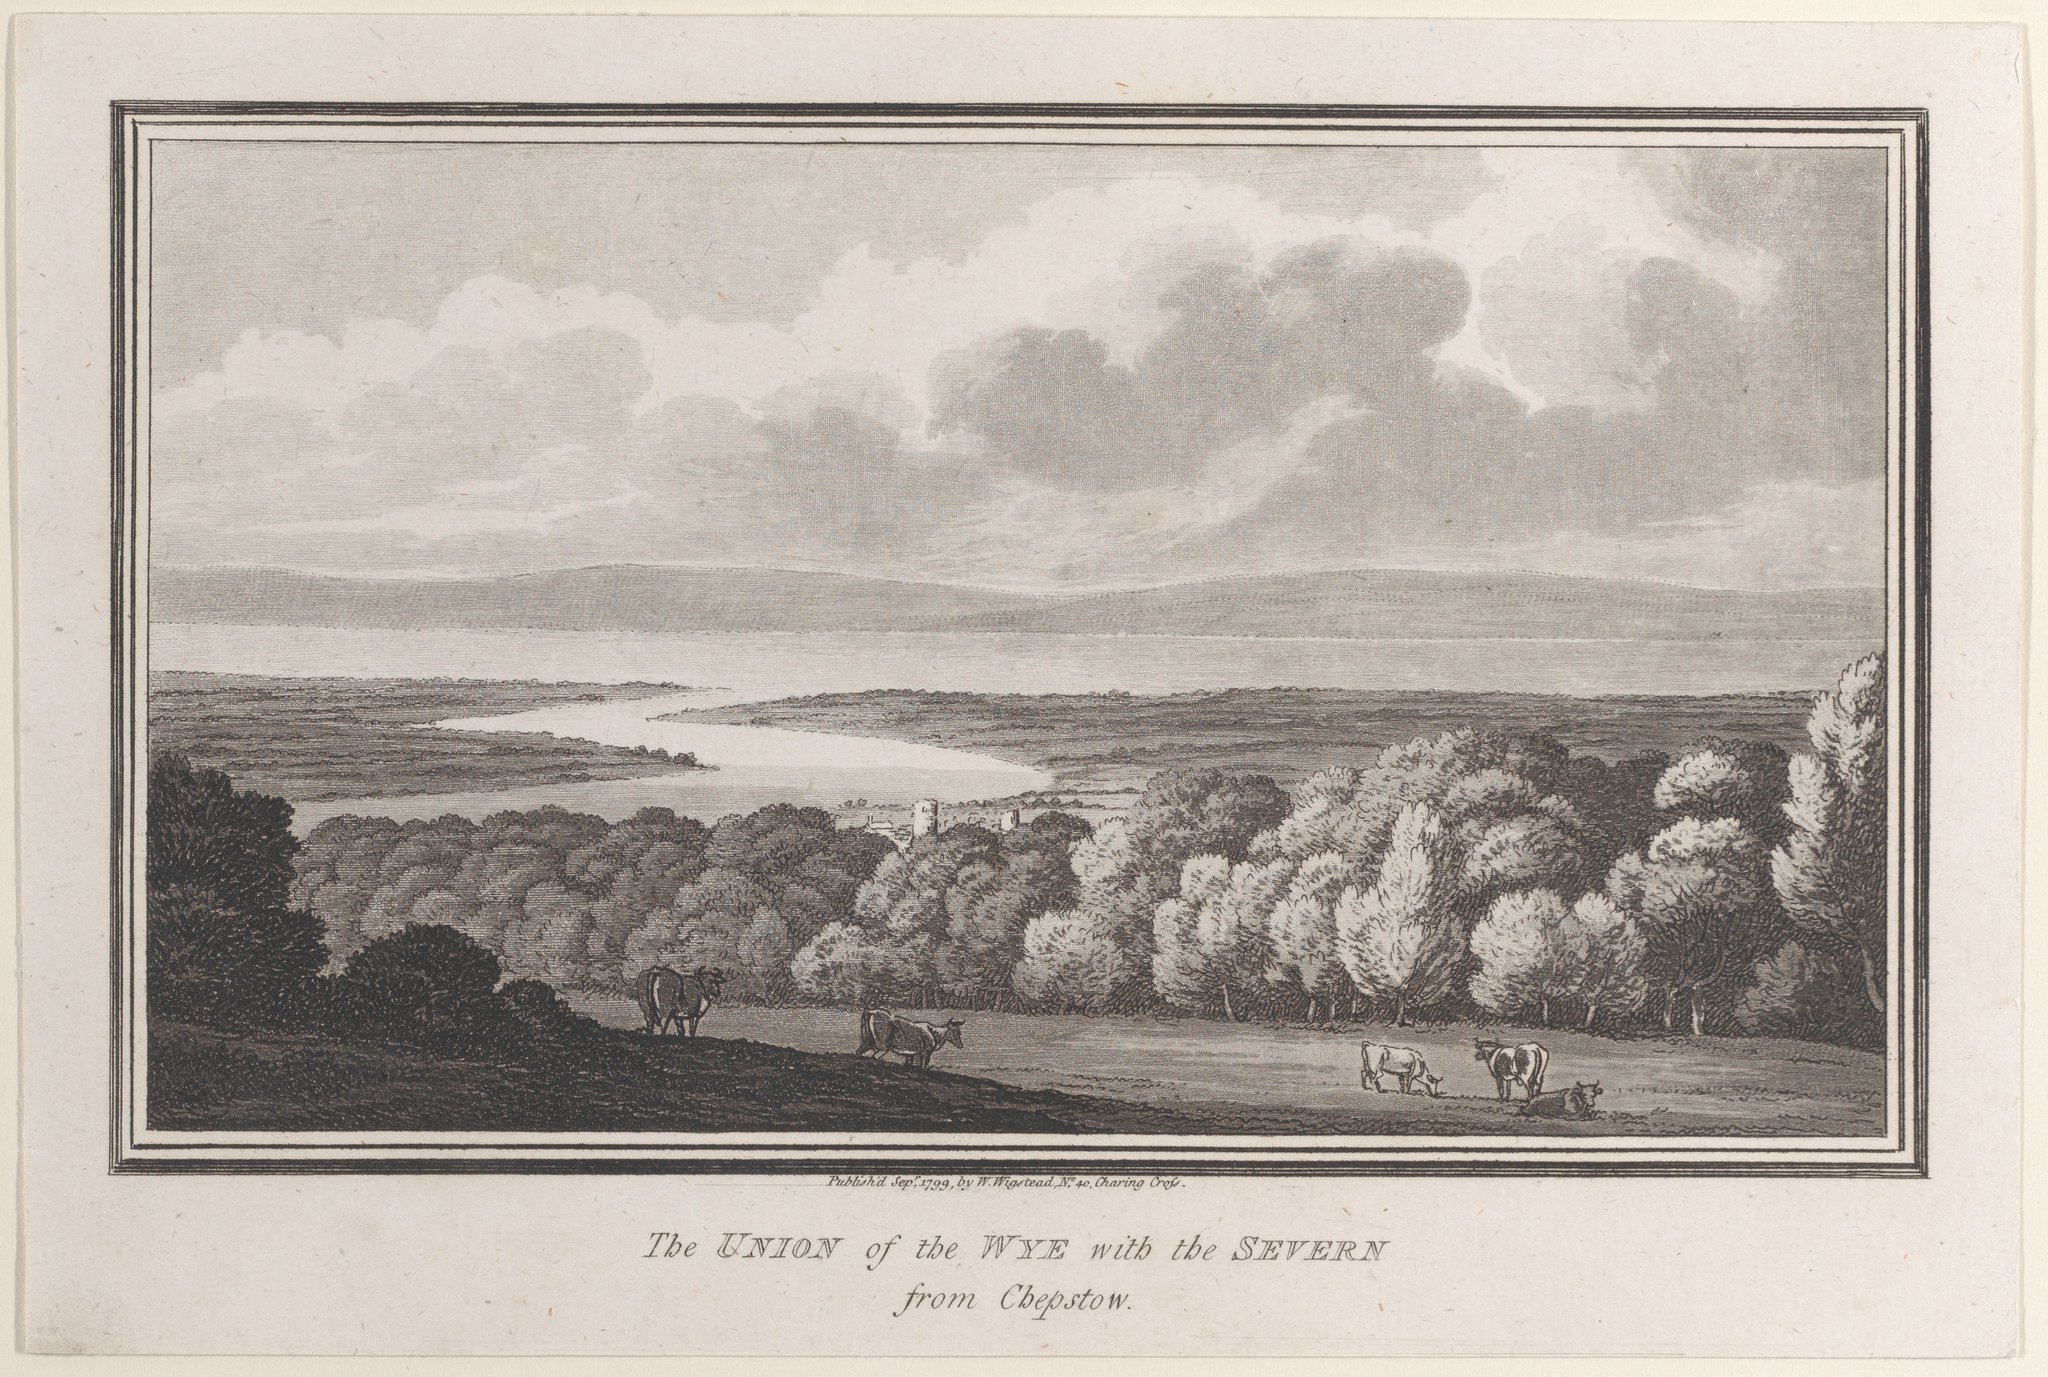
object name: print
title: The Union of the Wye with the Severn from Chepstow, from "Remarks on a Tour to North and South Wales, in the year 1797"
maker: john hill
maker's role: artist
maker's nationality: british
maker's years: 1714-1775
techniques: aquatint, etching